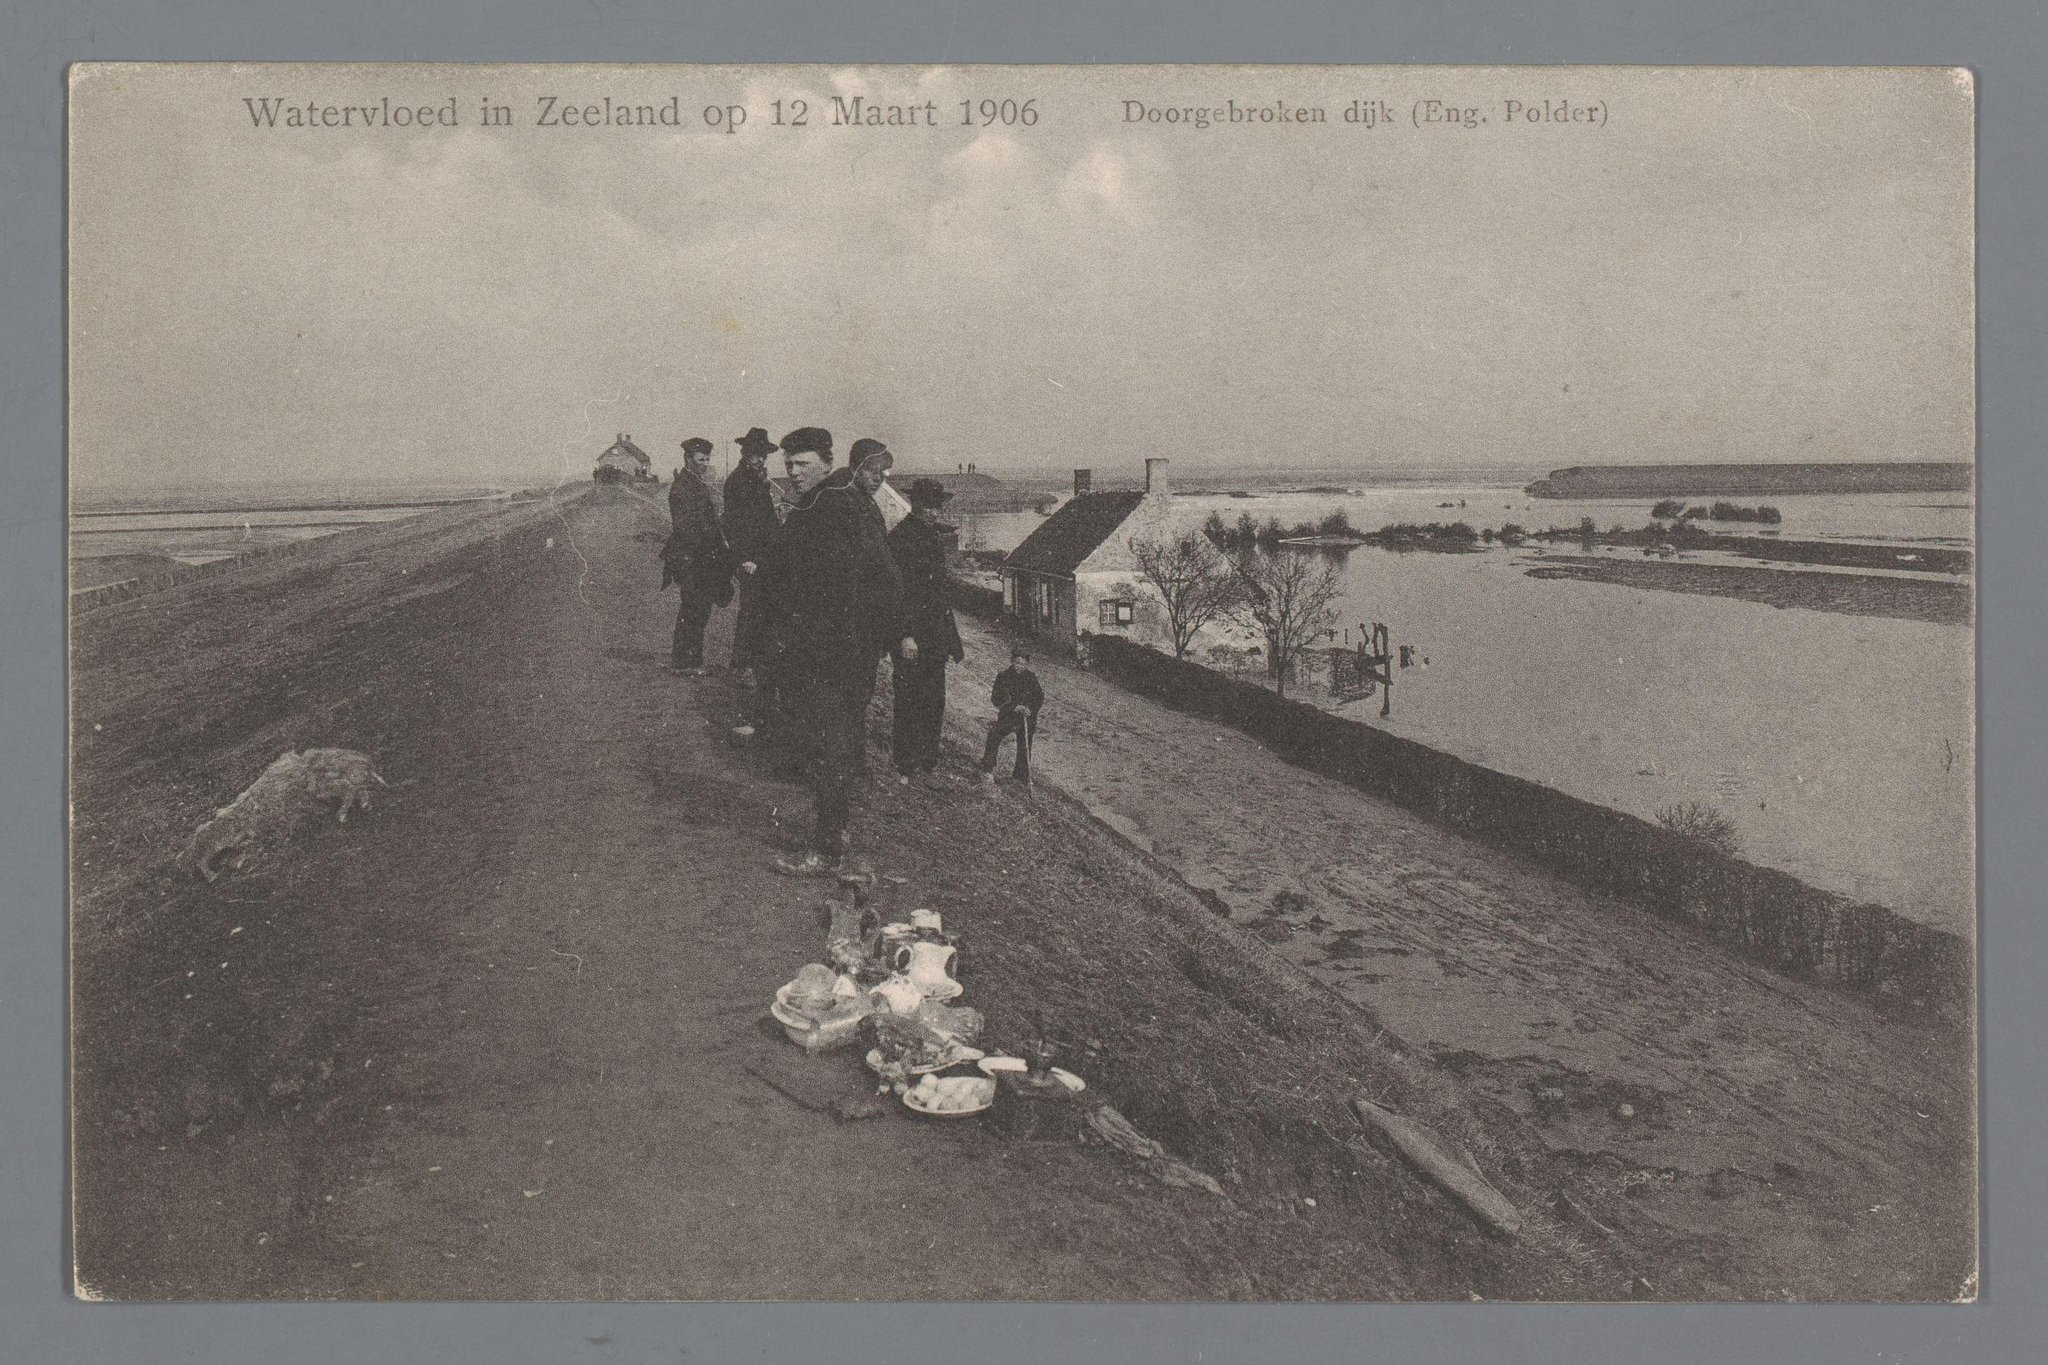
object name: ansichtkaart, prentbriefkaart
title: Watervloed in Zeeland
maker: p.j. daniëlse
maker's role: publisher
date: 1906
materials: paper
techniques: printing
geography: middelburg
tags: zeeland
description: Briefkaart, zwart-wit. Watersnood 12 maart 1906.